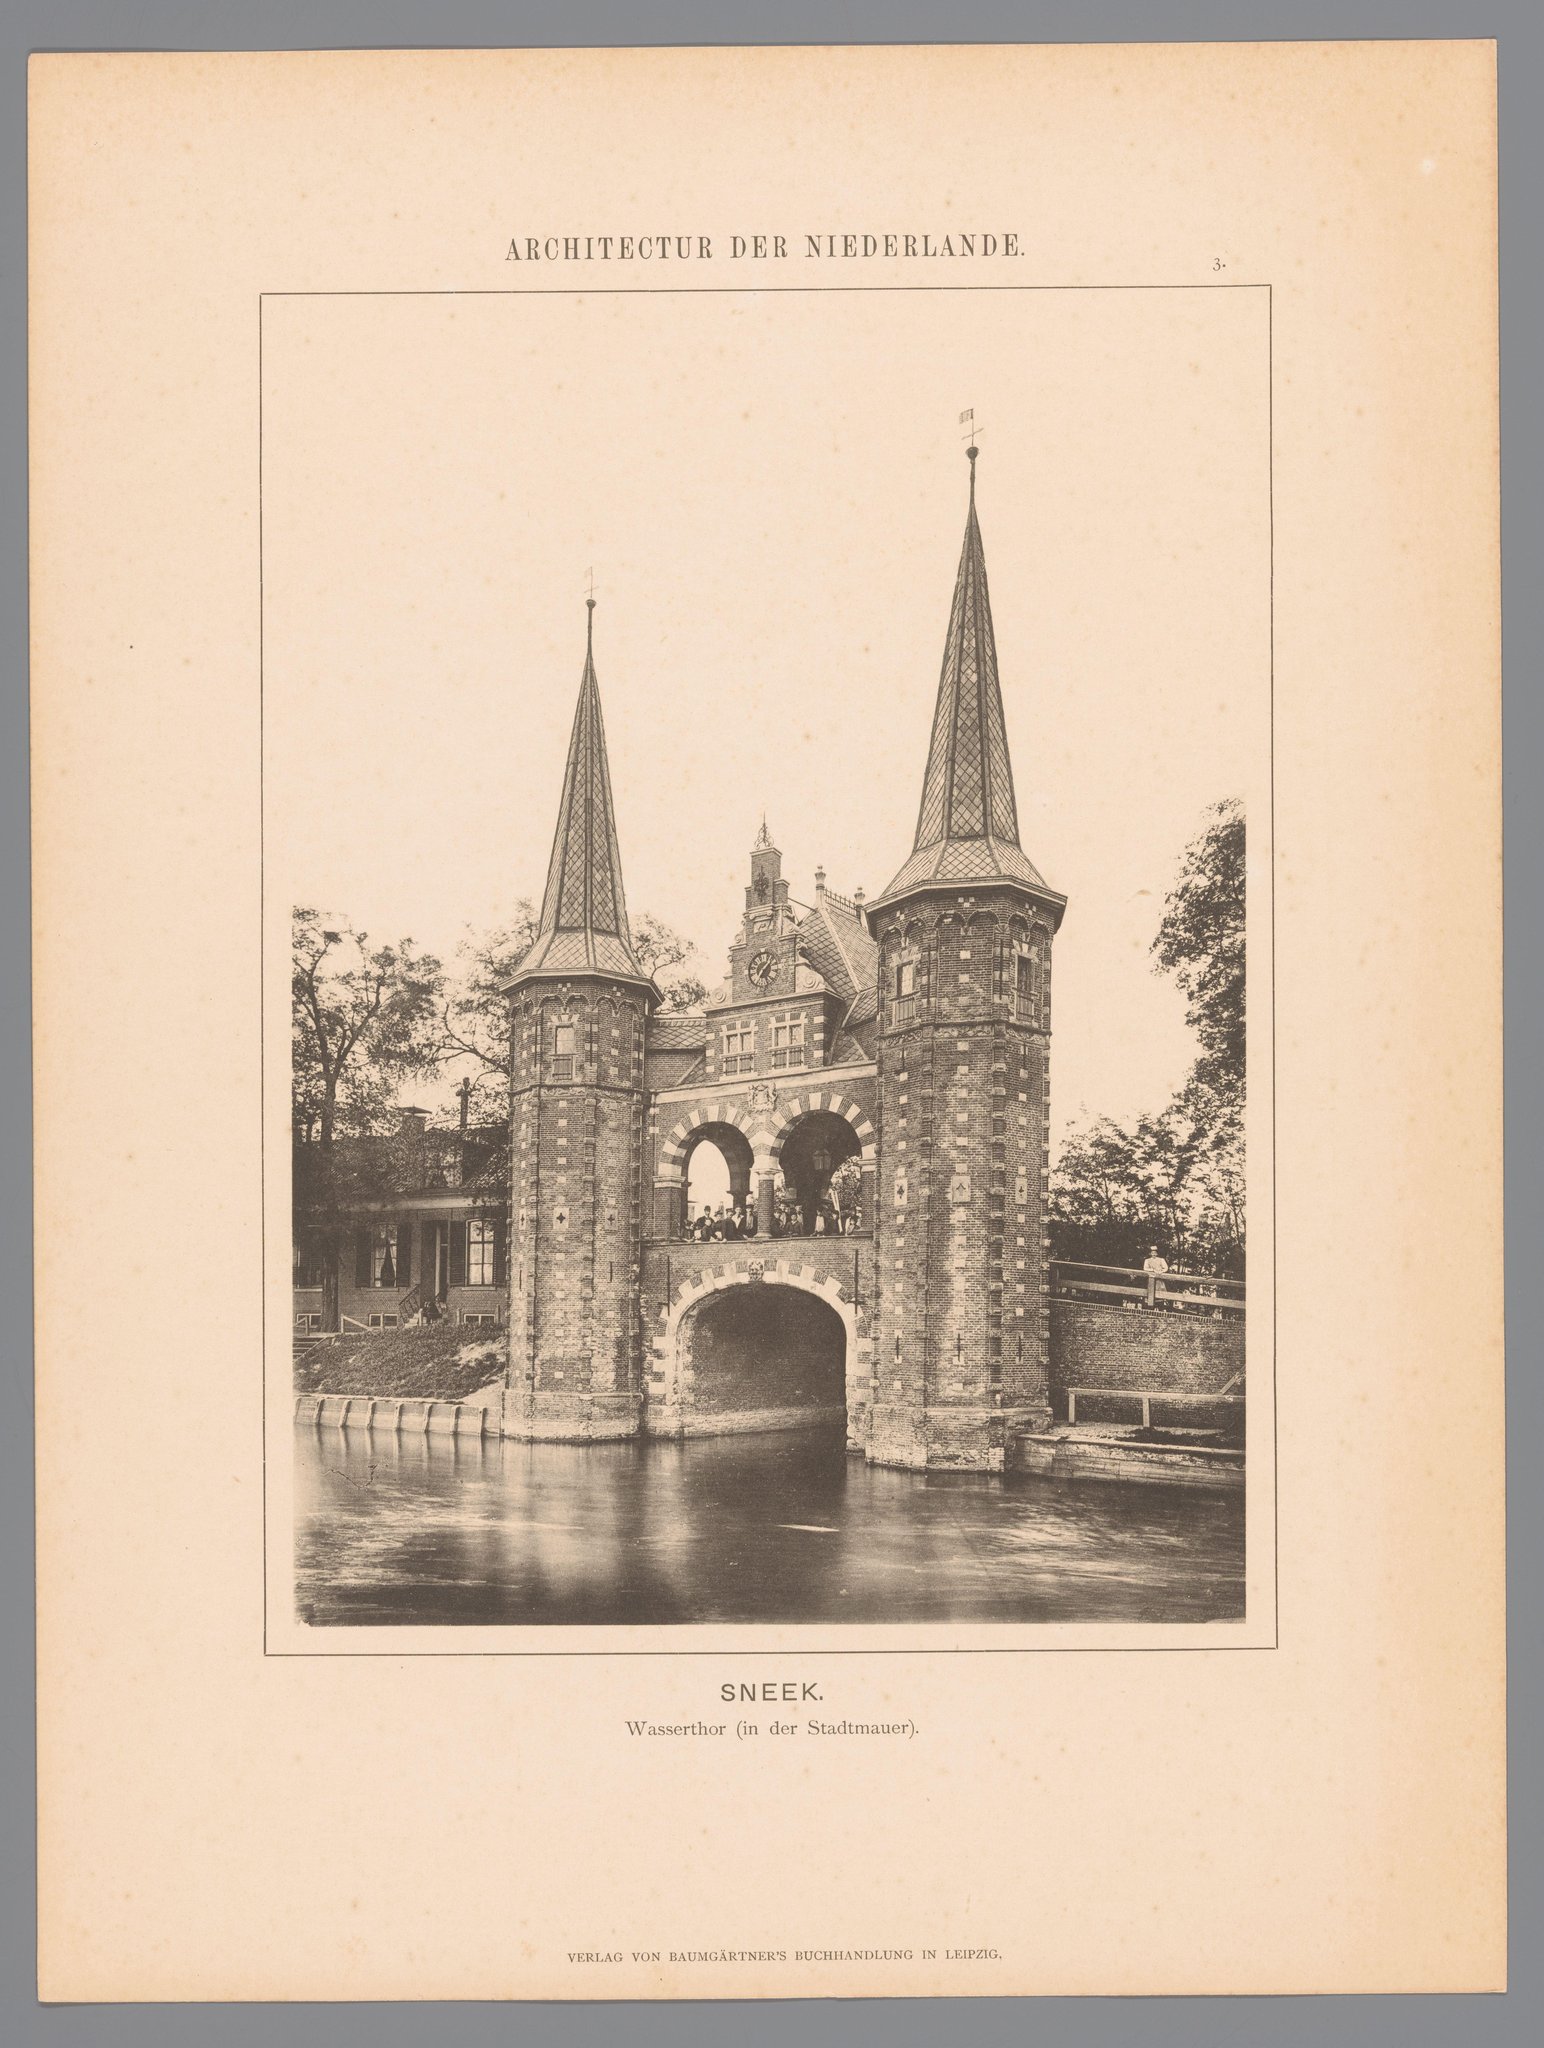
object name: photomechanical print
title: Sneek Wasserthor (in der Stadtmauer)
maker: Anonymous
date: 1894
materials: paper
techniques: photograph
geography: leipzig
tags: bridge with structure, i.e. cover or buildings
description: Afdruk uit: Krook, L. Architectur der Niederlande. Leipzig: Baumgärtner's Buchhandlung, 1894.